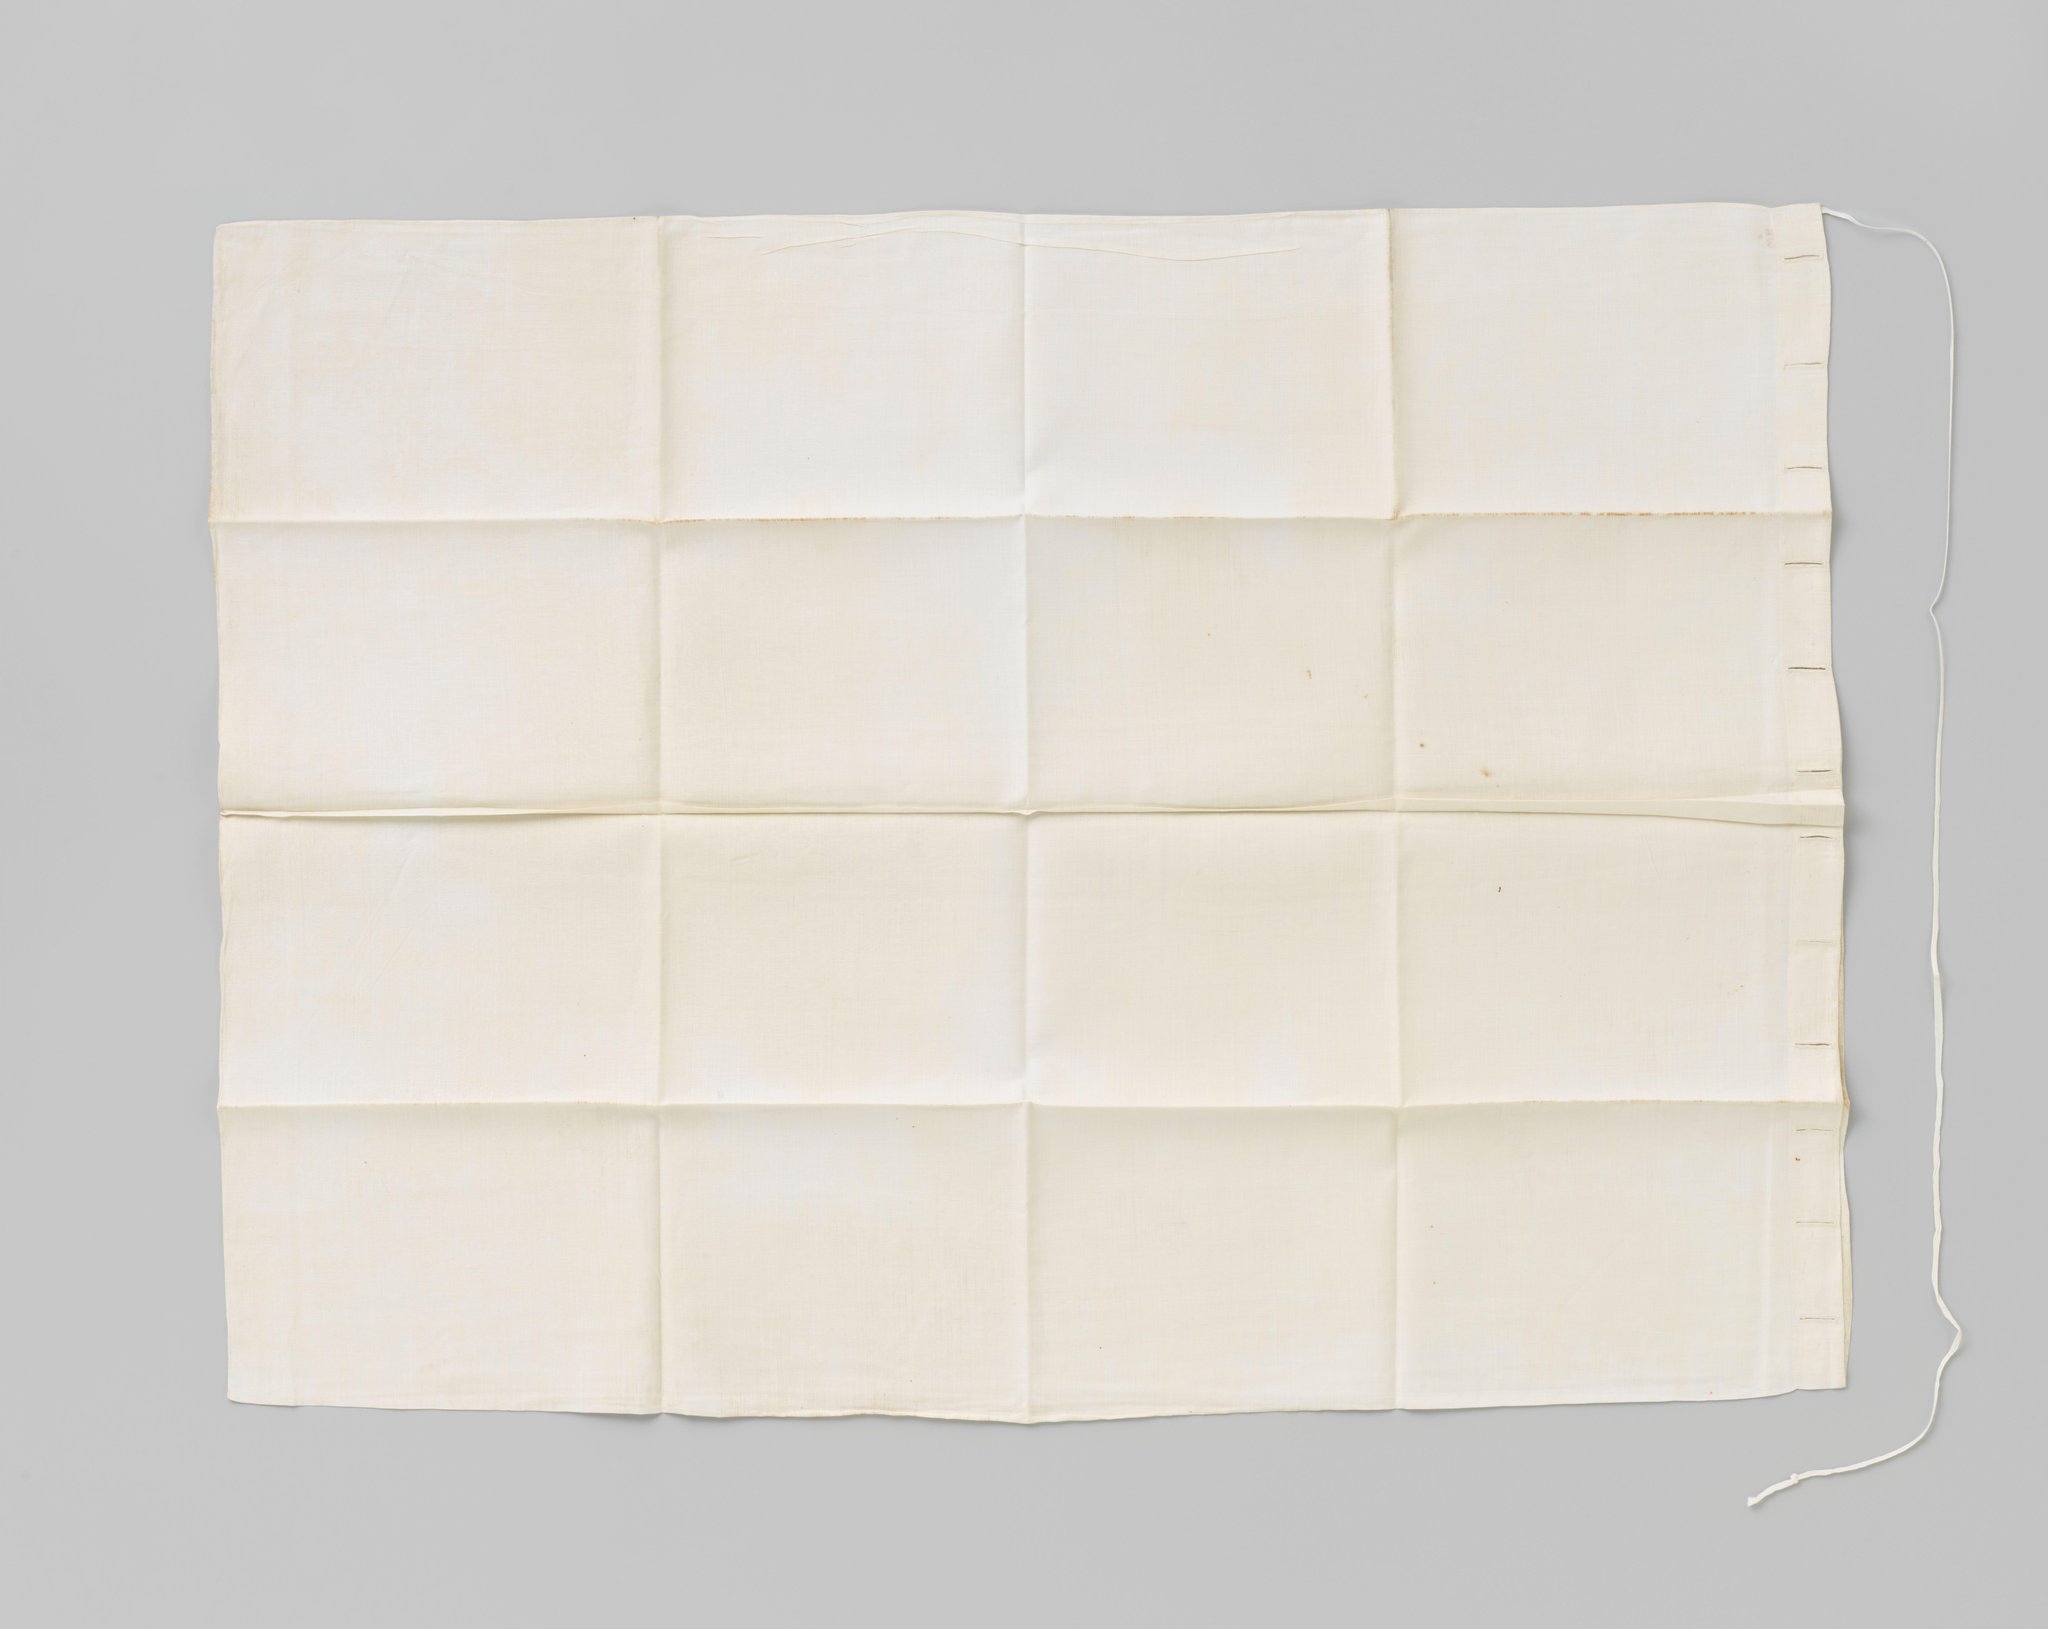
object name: sloop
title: Sloop van wit linnen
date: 1831-1875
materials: linen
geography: northern netherlands